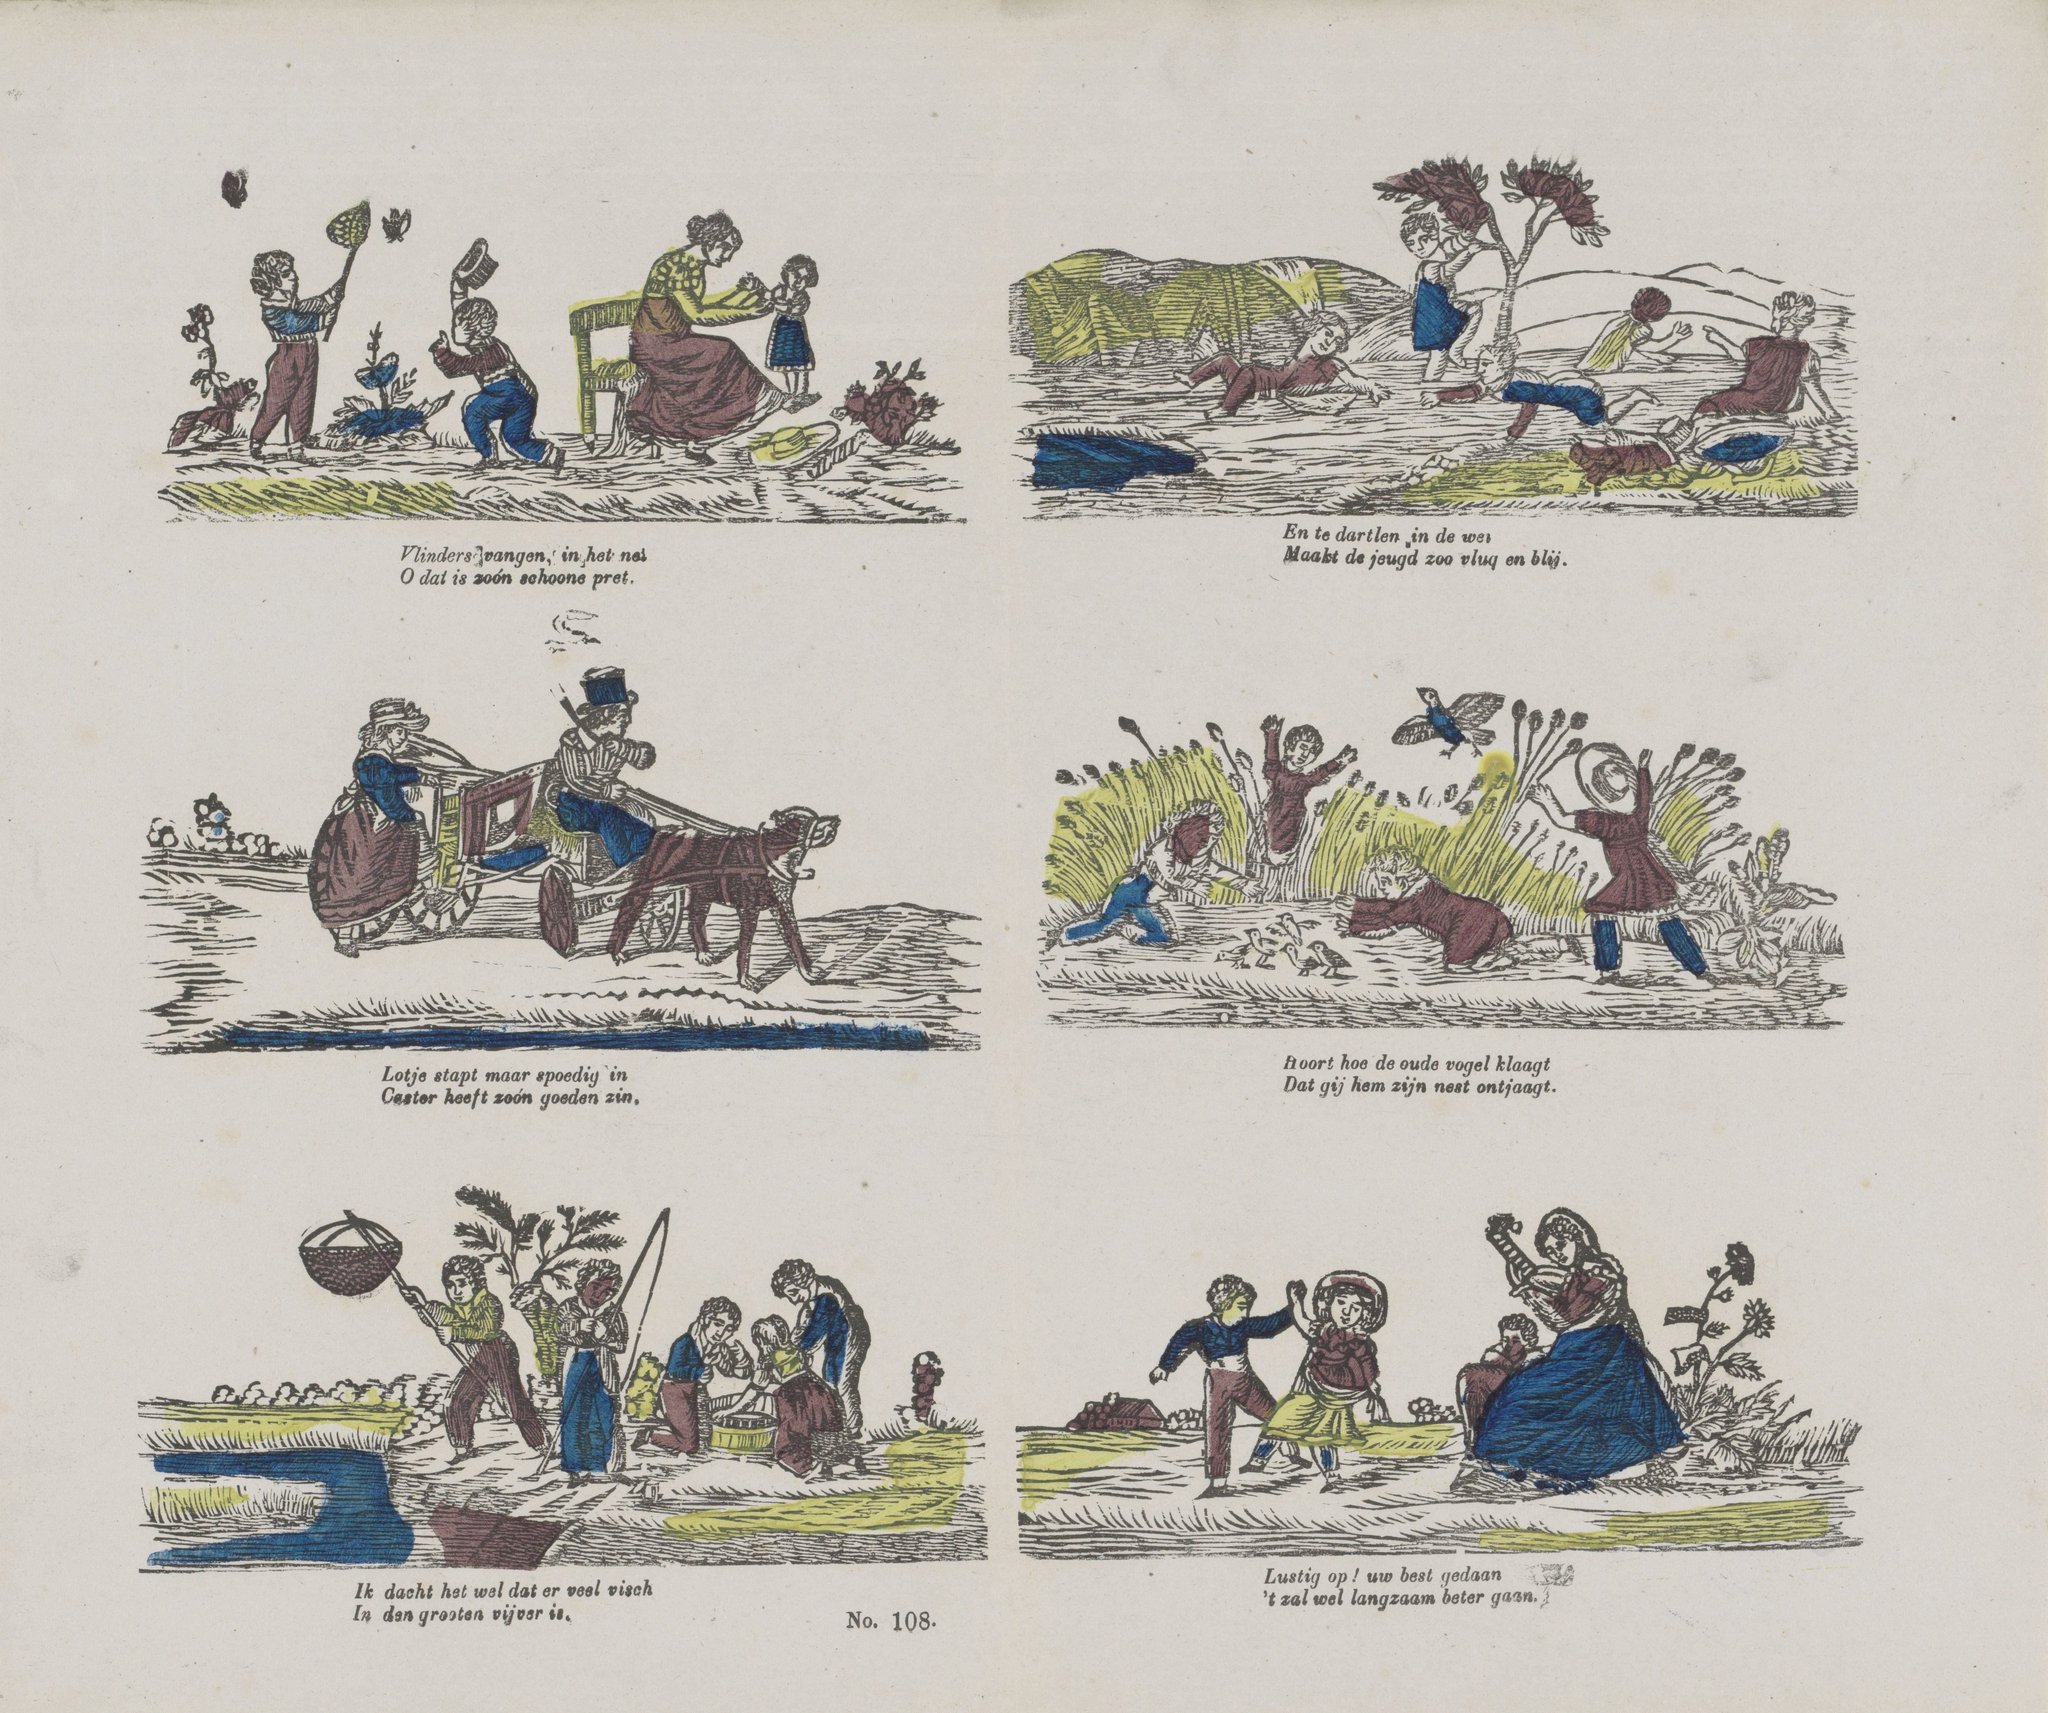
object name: popular print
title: Kindervermaken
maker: Anonymous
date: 1848-1881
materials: paper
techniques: colour, letterpress printing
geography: netherlands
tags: children's games and plays, dancing, child playing with animals, fishing (sports), swimming (sport)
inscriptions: collector's mark: Lugt 2760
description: Blad met 6 voorstellingen van kinderspelen en bezigheden, zoals zwemmen, vissen en dansen. Onder elke voorstelling een tweeregelig vers. Genummerd midden onder: No. 108.